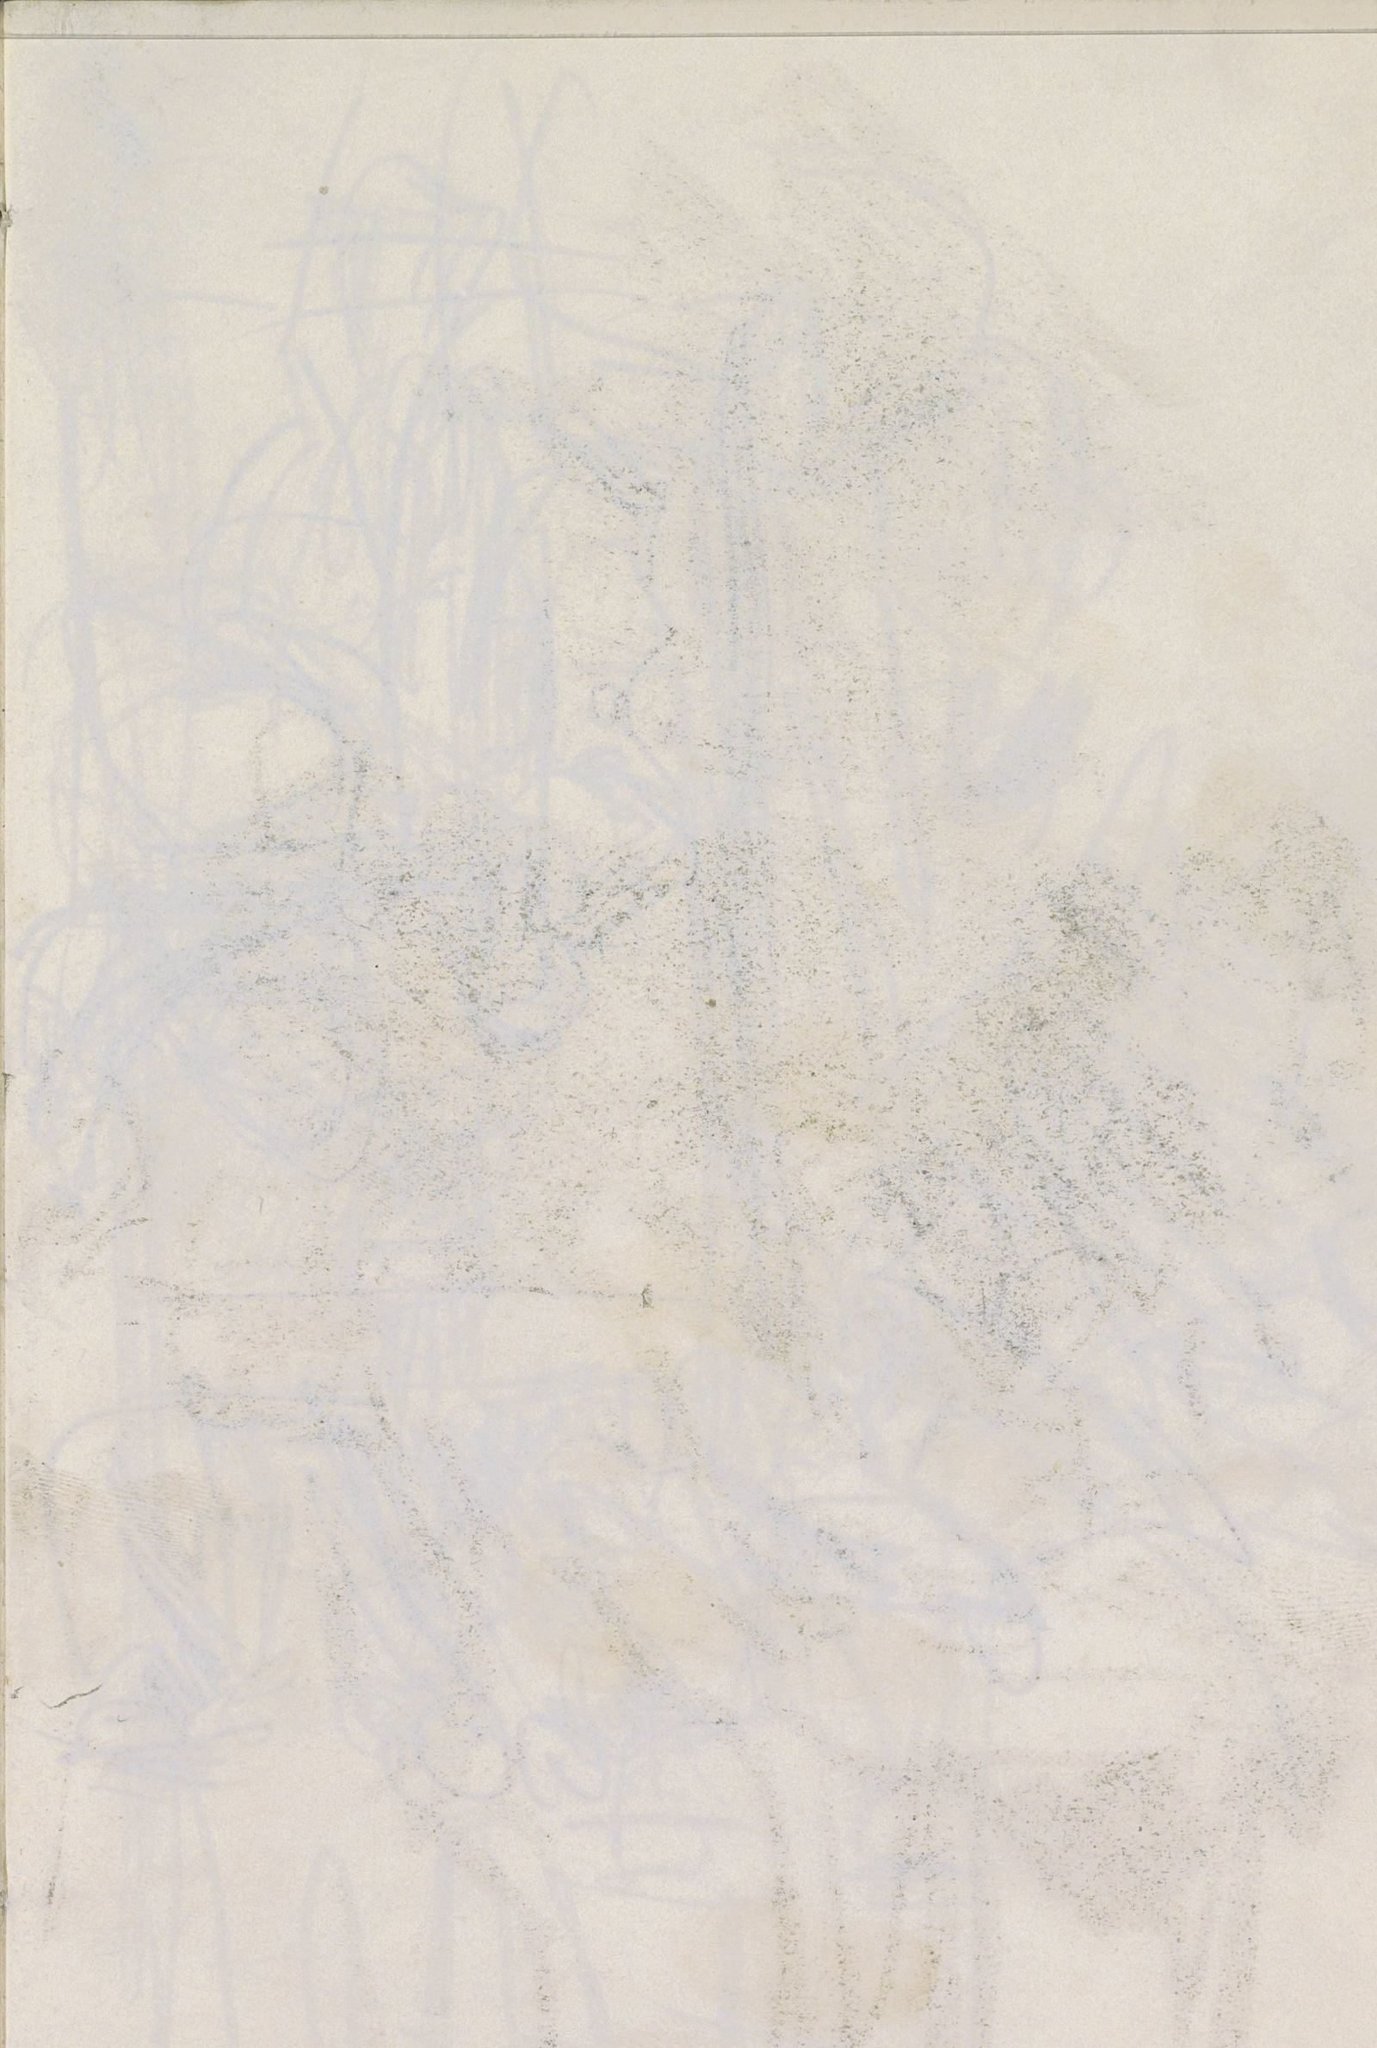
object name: sketchbook leaf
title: Abklatsch van de krijttekening op blad 13 verso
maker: isaac israels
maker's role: draughtsman, painter, print maker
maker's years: 1865-1934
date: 1875-1934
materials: paper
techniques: printmaking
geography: paris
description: Blad 14 recto uit schetsboek L met 42 bladen.